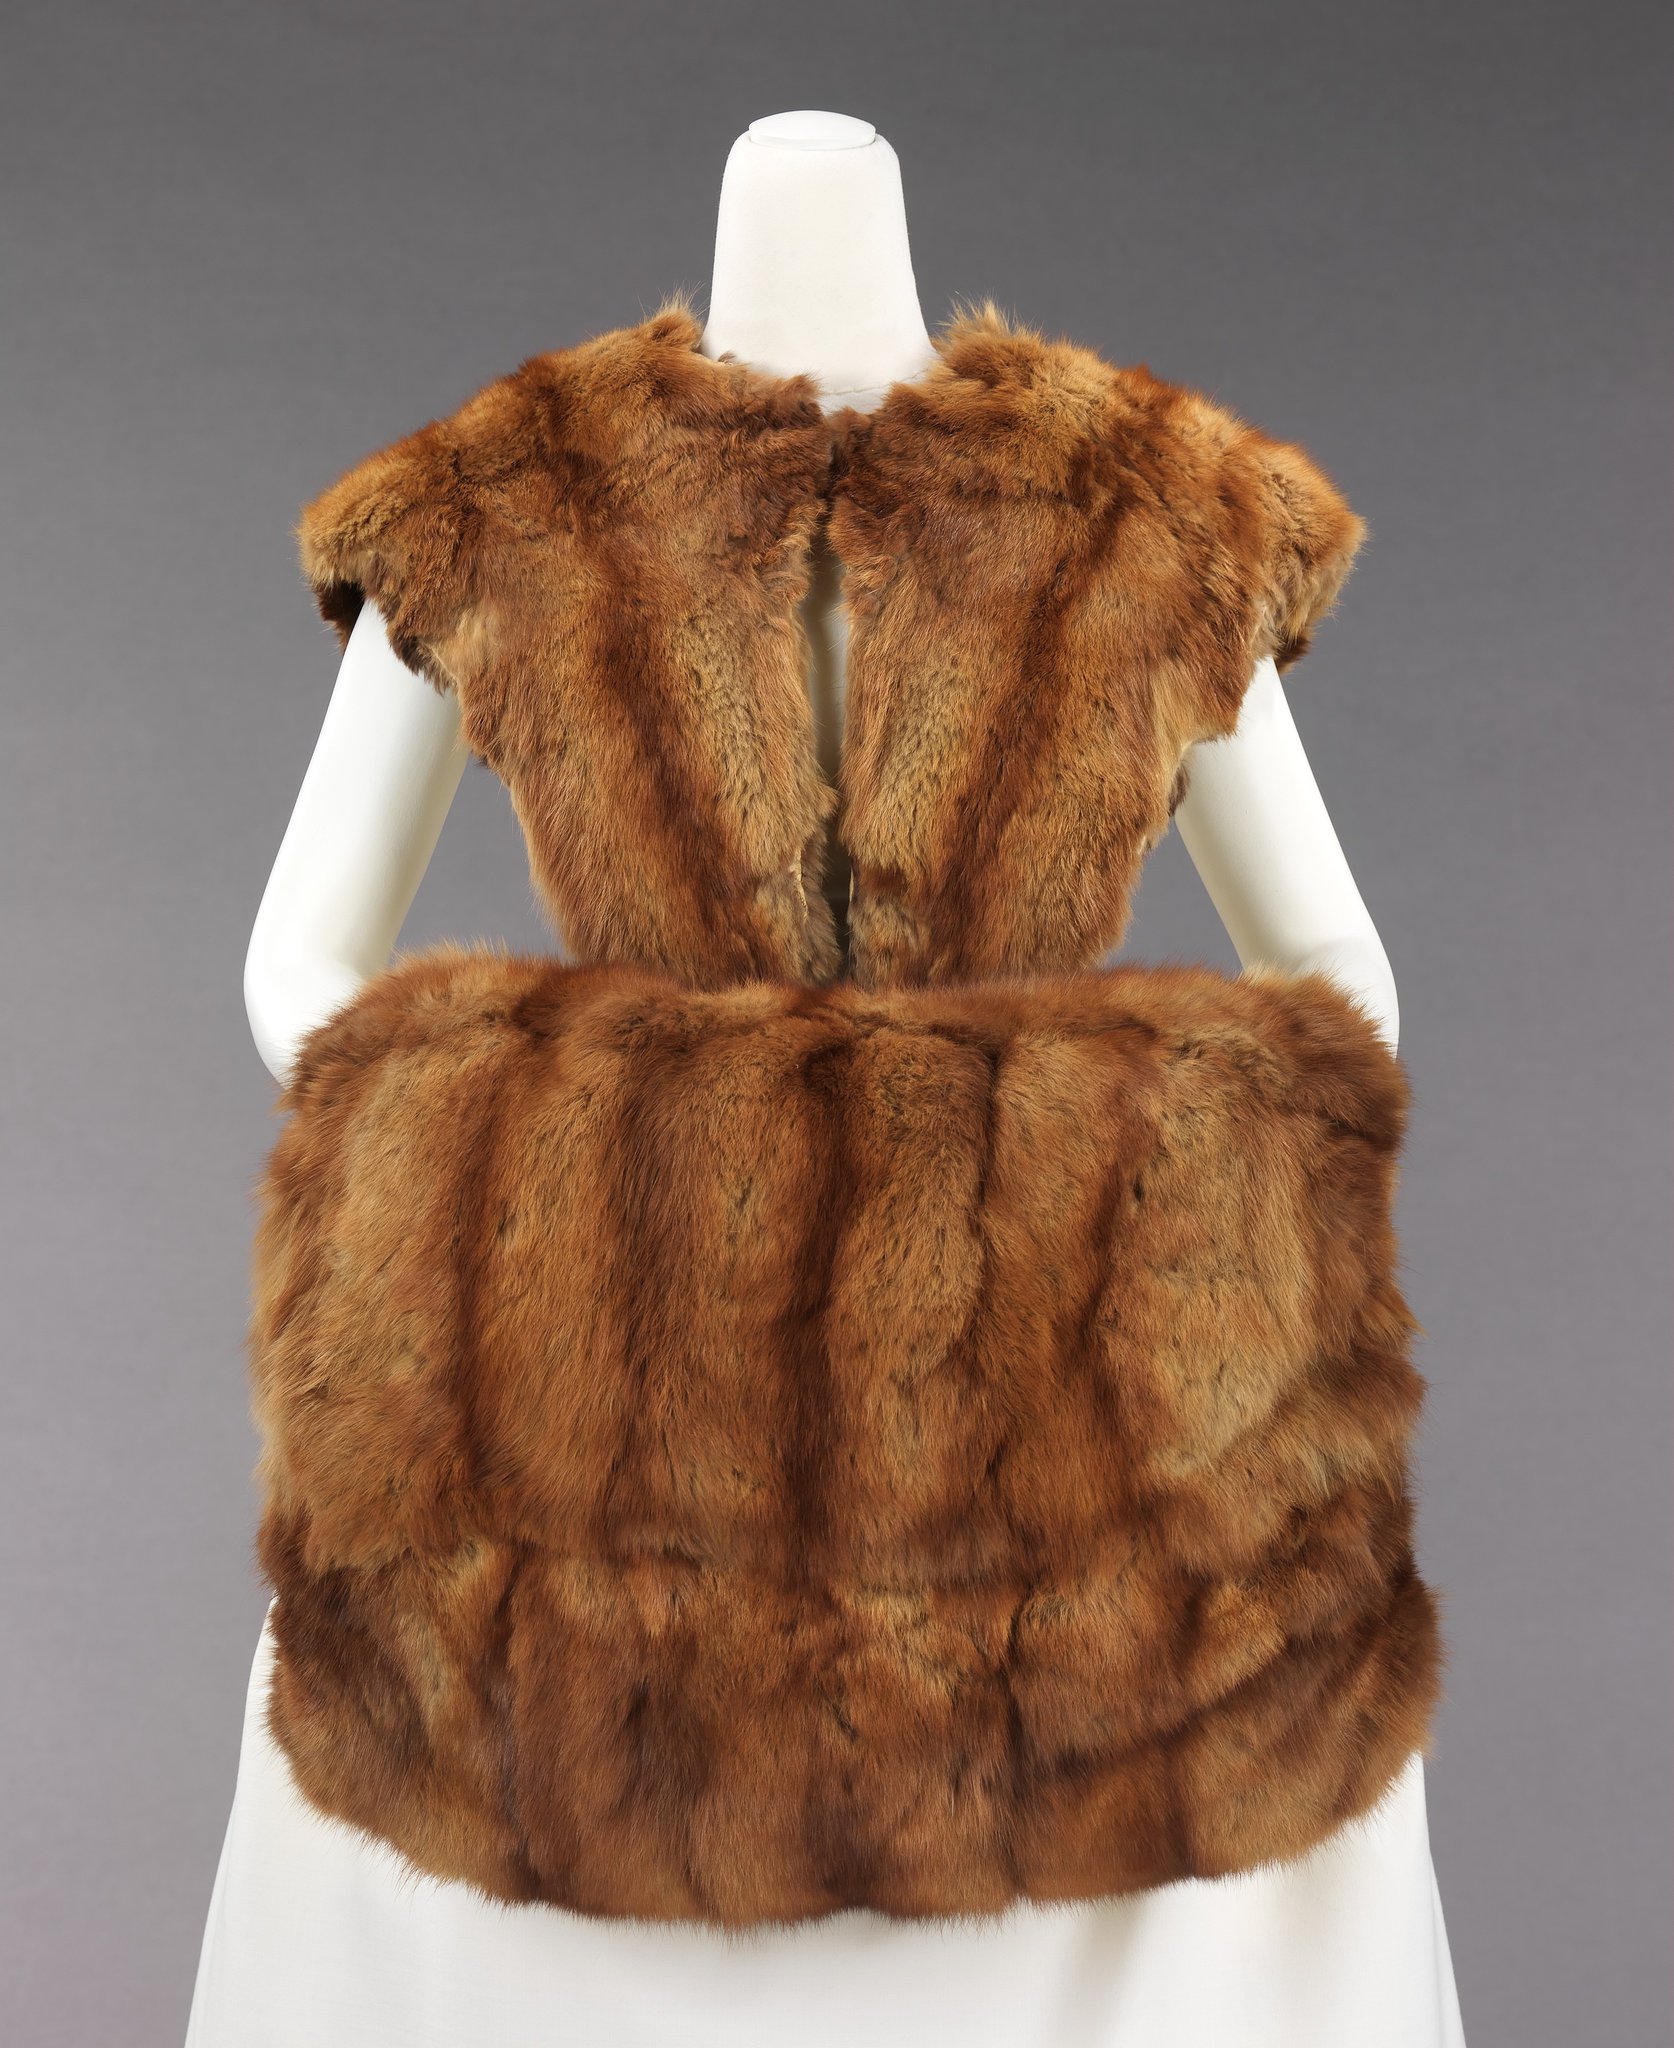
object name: accessory set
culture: american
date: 1820-1840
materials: fur, silk